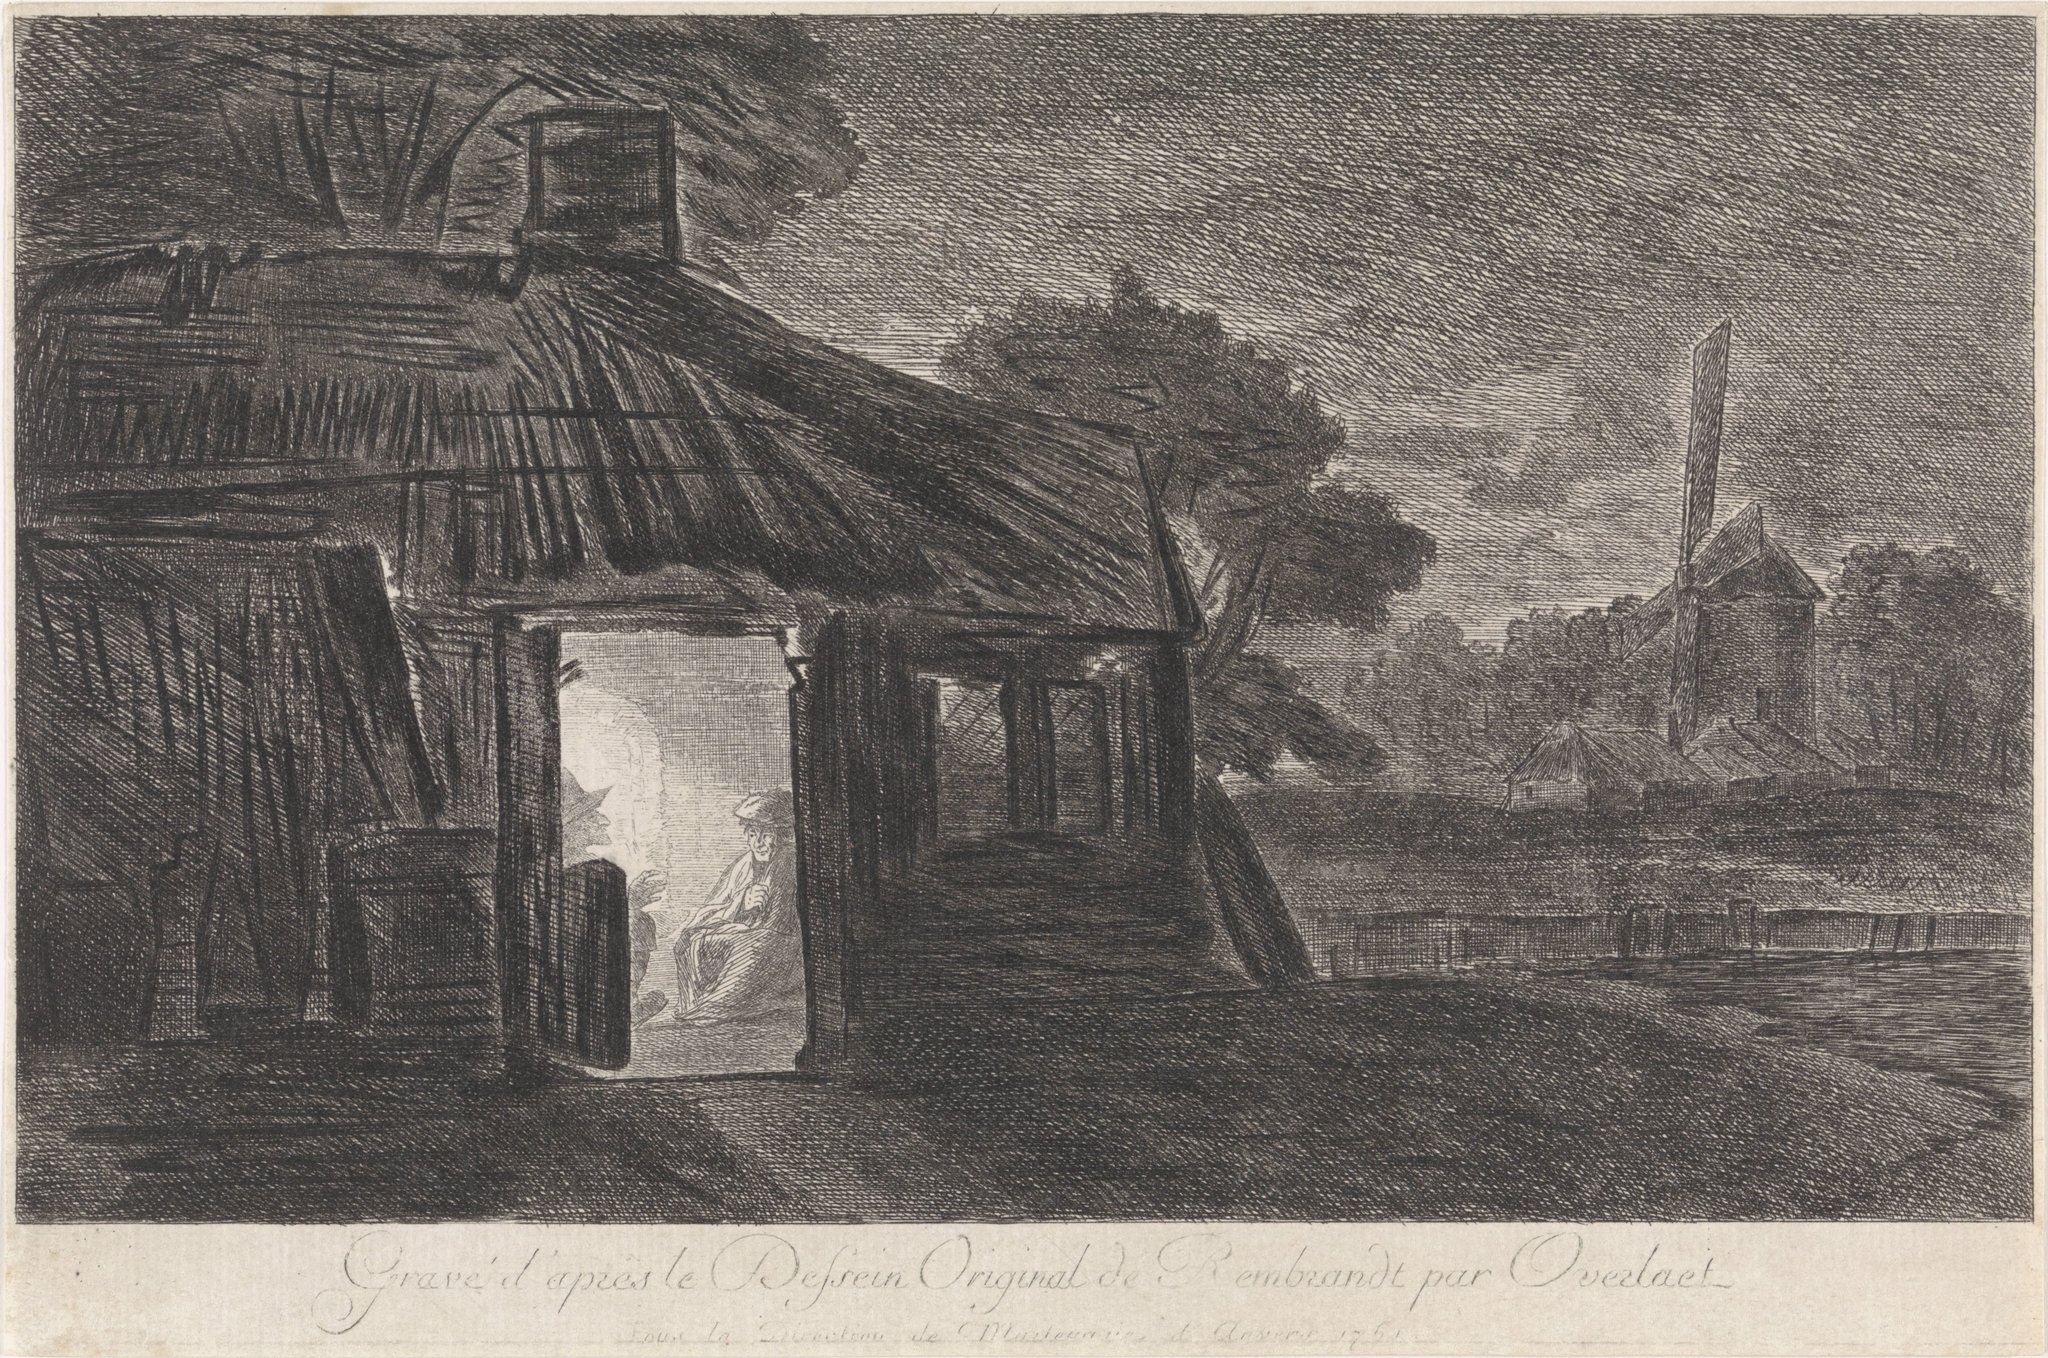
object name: print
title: Nachtstuk met twee figuren in een hut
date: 1761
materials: paper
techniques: etching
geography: antwerp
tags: warming oneself at a fire (or hearth, stove, fire-pan, brazier)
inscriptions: collector's mark: Lugt 2228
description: Landschap met links een hut met openstaande deur waardoor men een vrouw en een man bij het vuur ziet zitten.